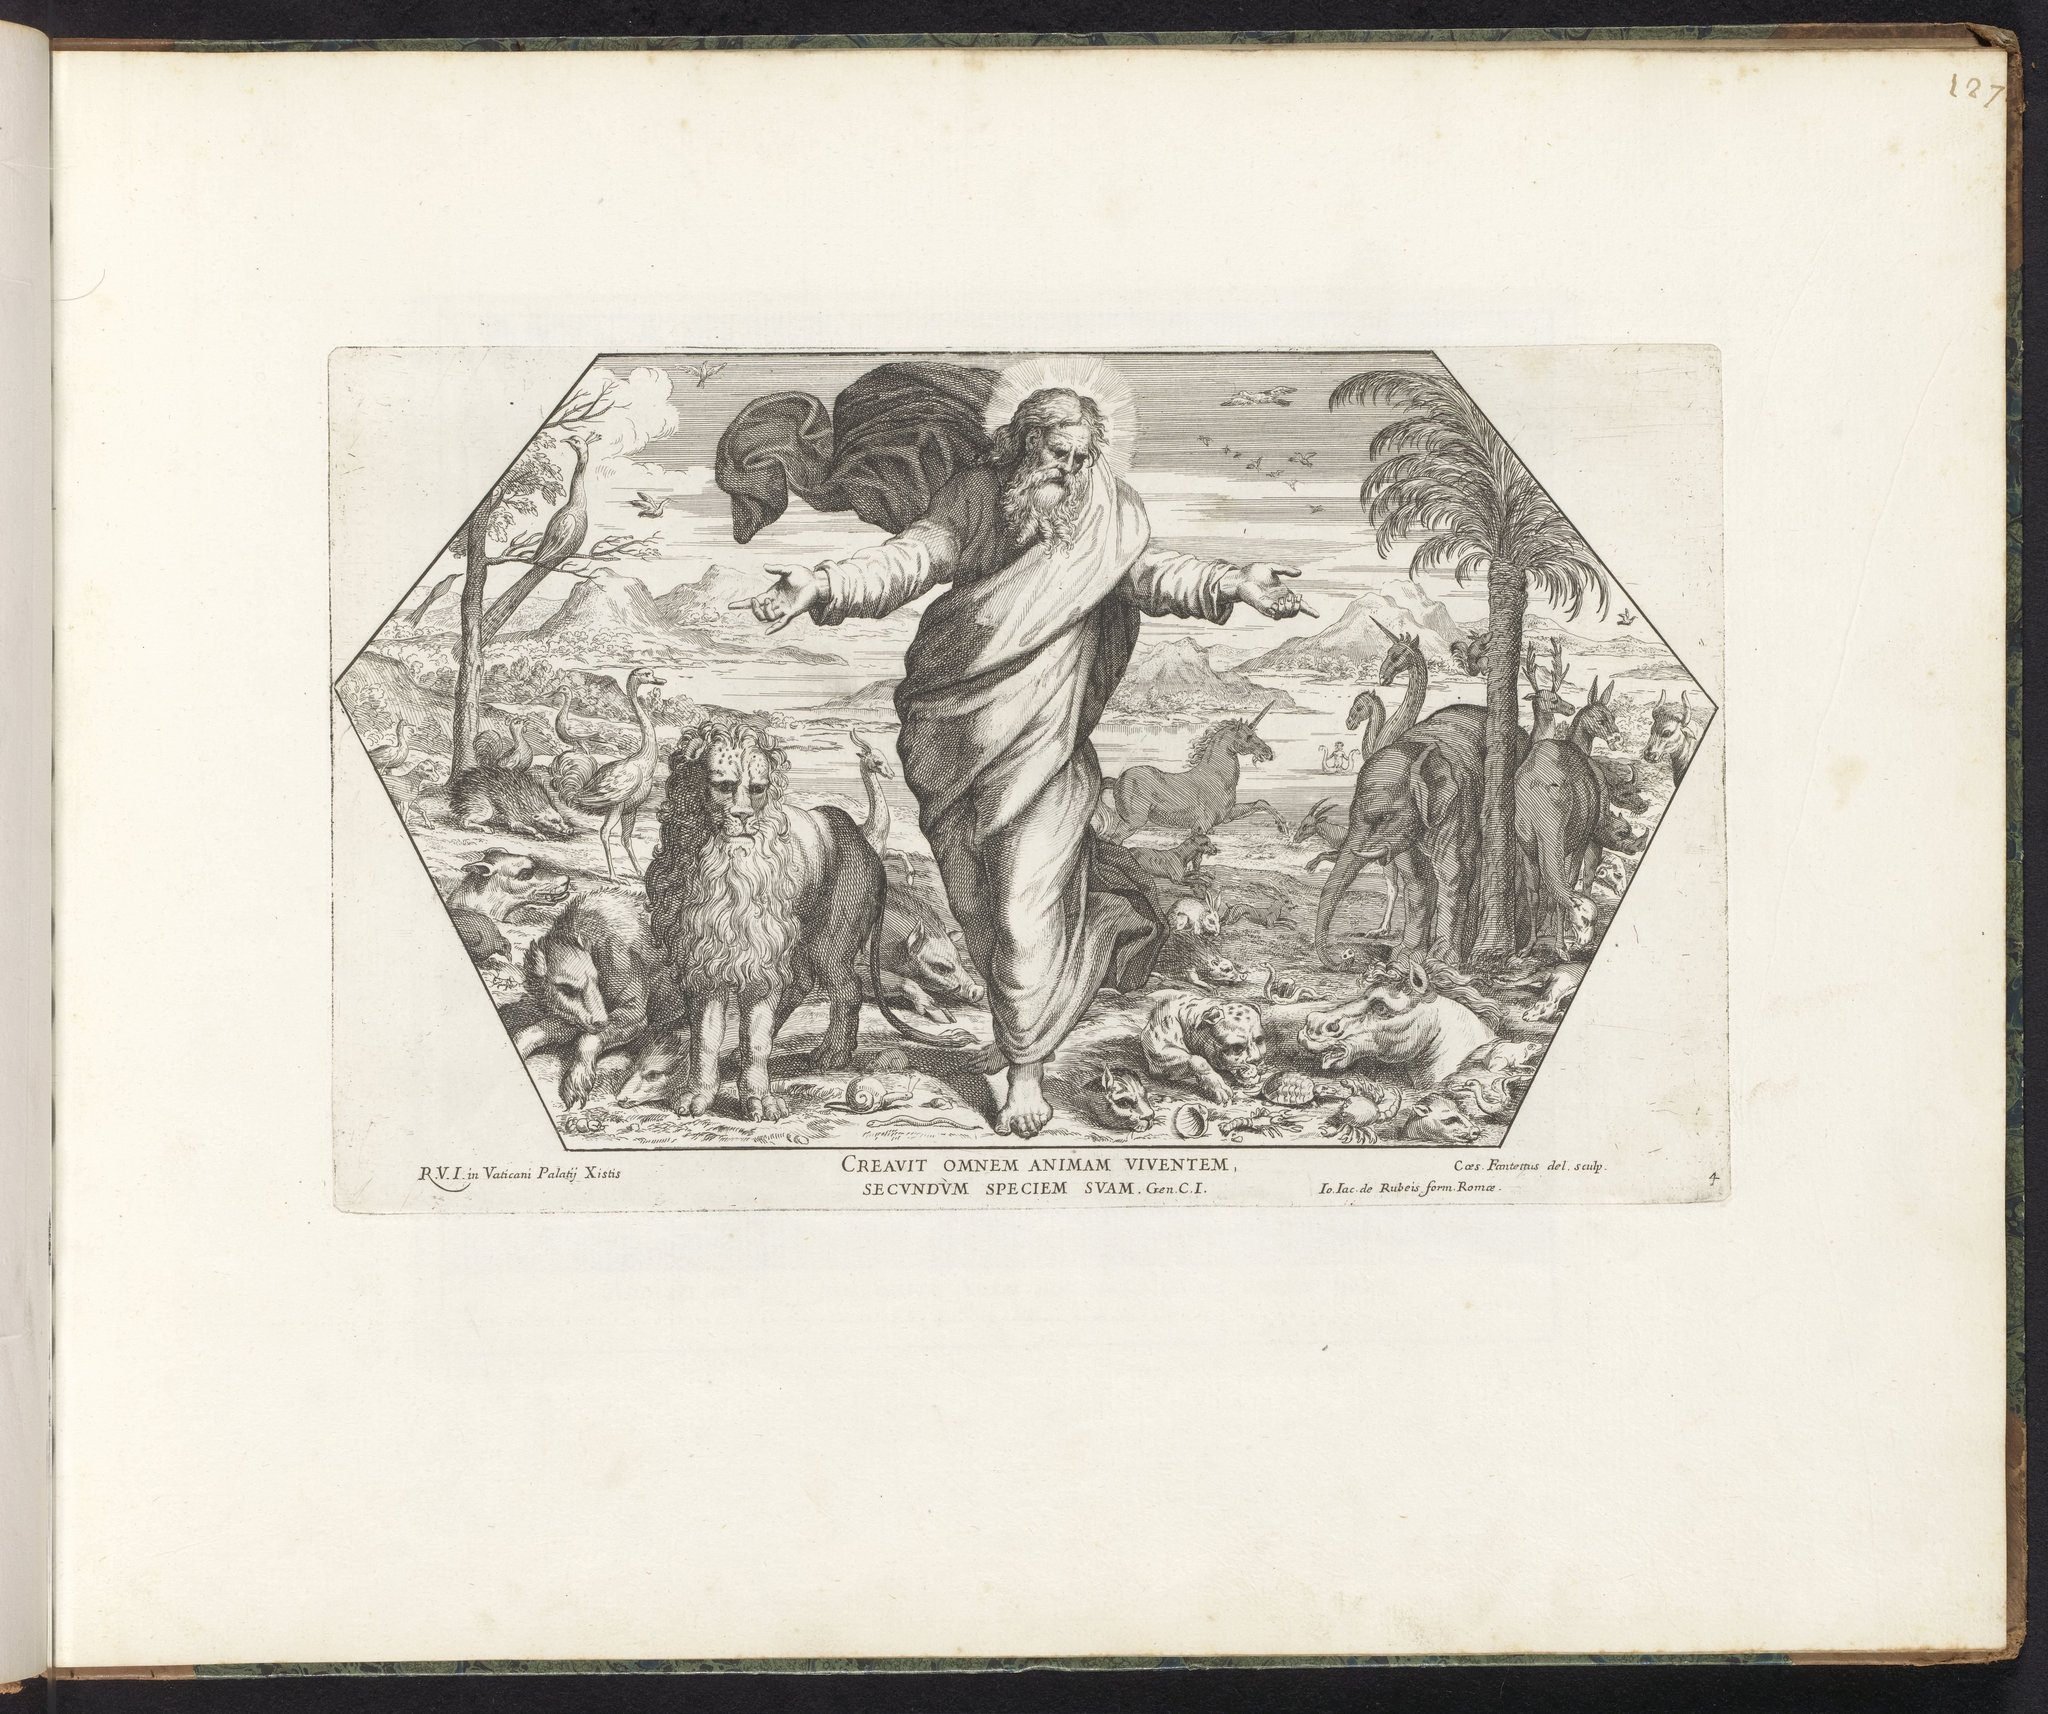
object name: album leaf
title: Rafaël Bijbel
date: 1675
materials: paper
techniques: etching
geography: vatican city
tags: creation of the animals ~ genesis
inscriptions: number: ‘127’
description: God, een oude man met baard, staat in een landschap tussen verschillende dieren die hij zojuist geschapen heeft. Bijbelvers onder de voorstelling. Prent maakt deel uit van een album.